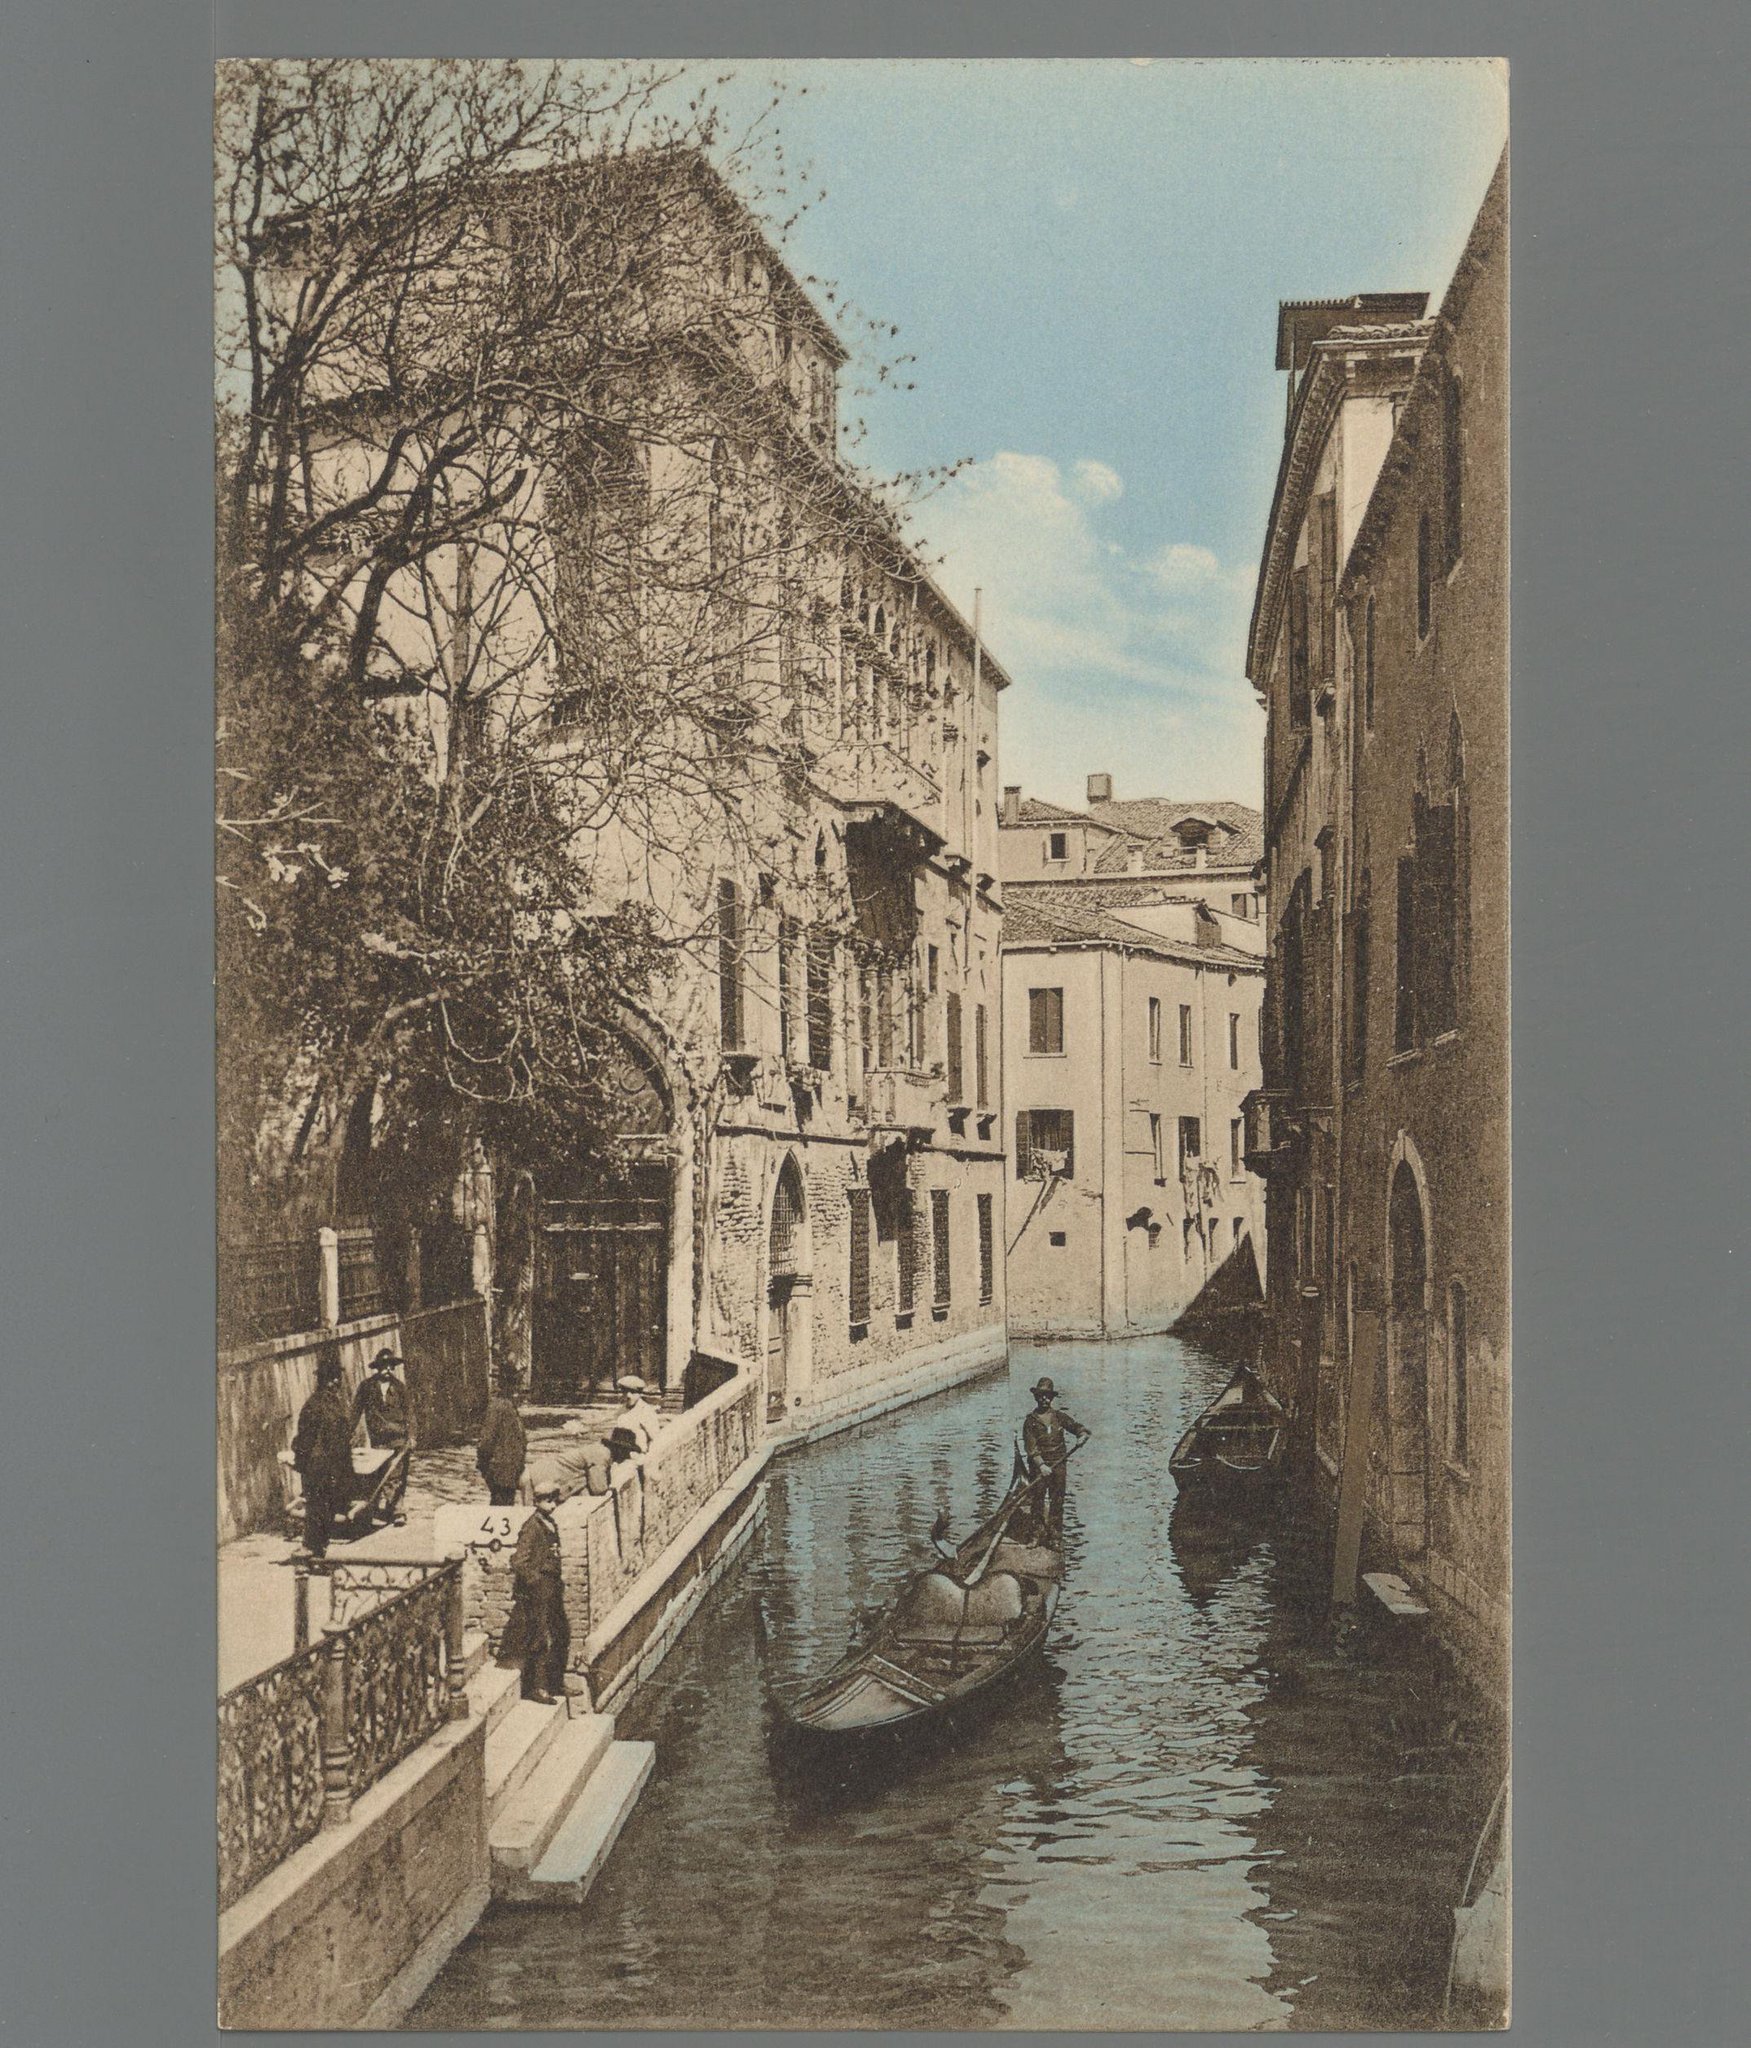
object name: ansichtkaart, prentbriefkaart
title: Venezia. Rio e palazzo Sanudo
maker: Anonymous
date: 1906-1920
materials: cardboard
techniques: photograph, lithograph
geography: venice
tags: river, gondola, city-view, and landscape with man-made constructions (+ city(-scape) with figures, staffage), venice